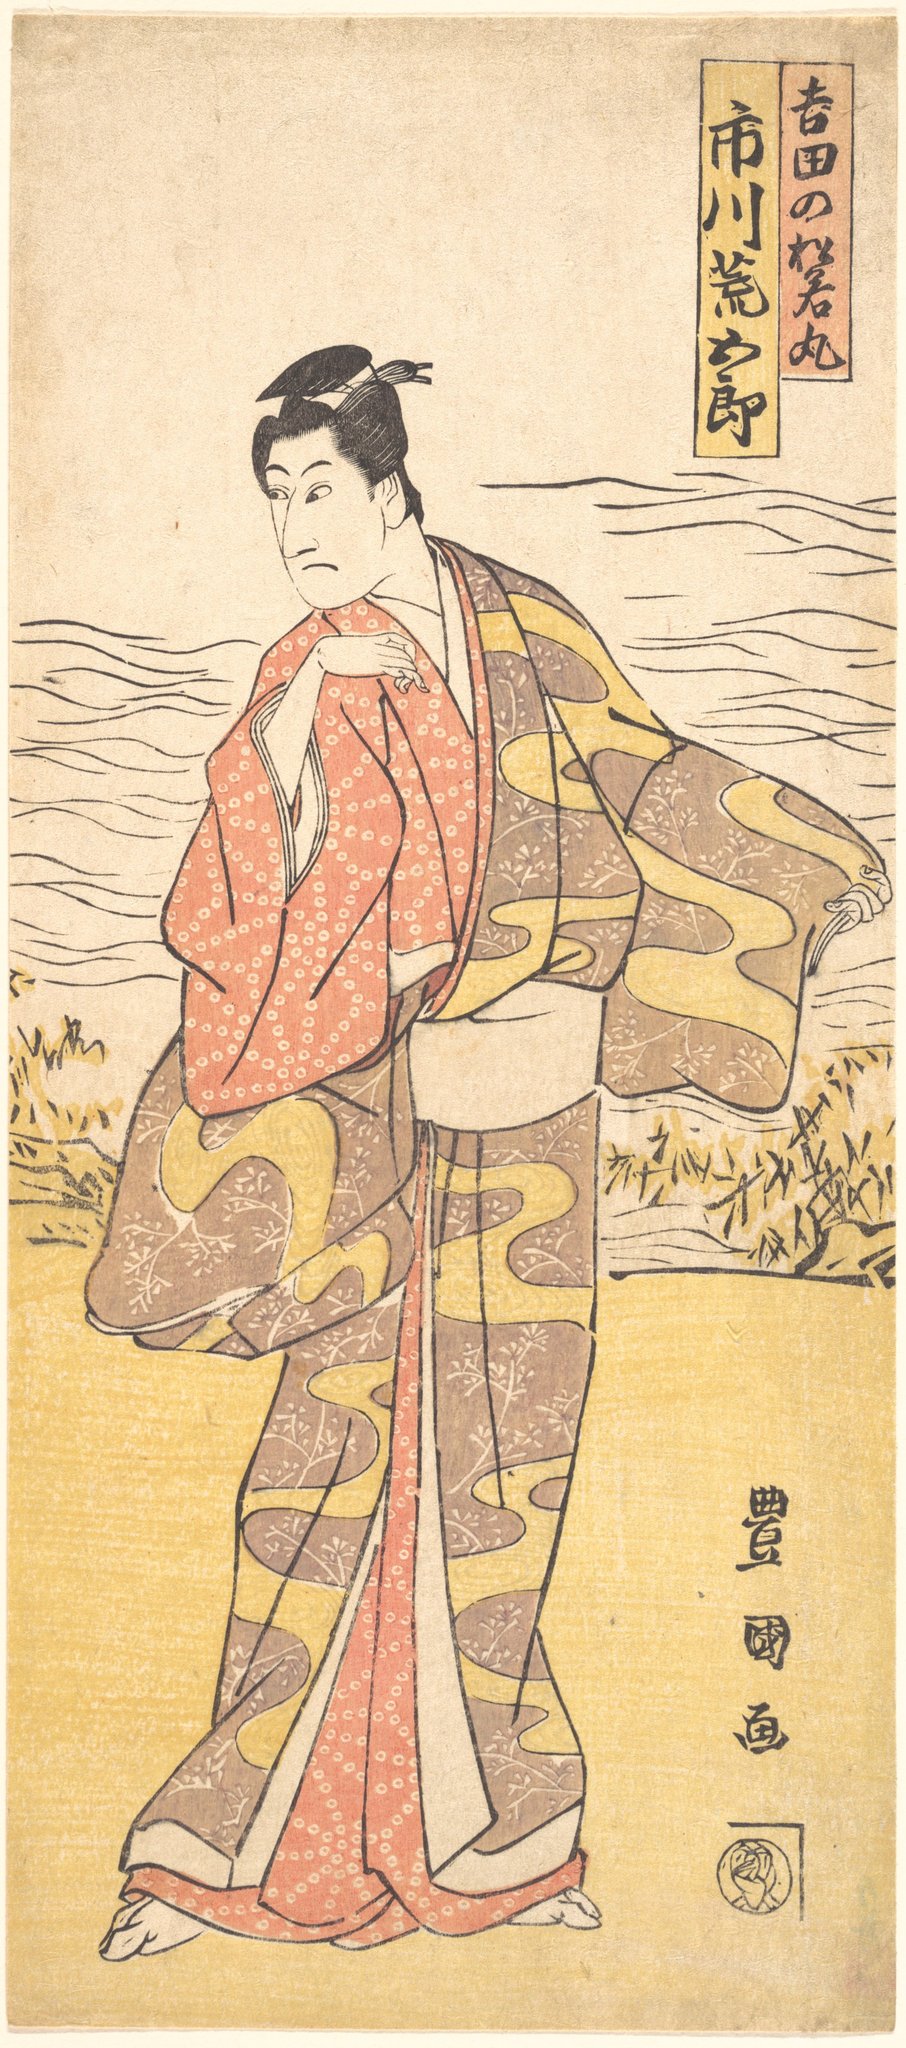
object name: print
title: The Actor Ichikawa Aragōrō as Yoshida no Matsuwaka-Maru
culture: japanese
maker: utagawa toyokuni i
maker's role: artist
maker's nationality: japanese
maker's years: 1769-1825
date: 1769-1825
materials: ink, paper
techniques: woodblock print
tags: men,actors